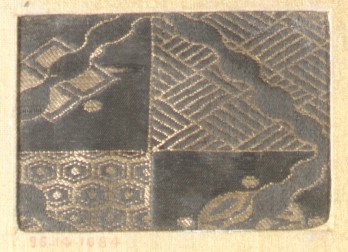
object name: piece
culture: japanese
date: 1701-1900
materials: silk